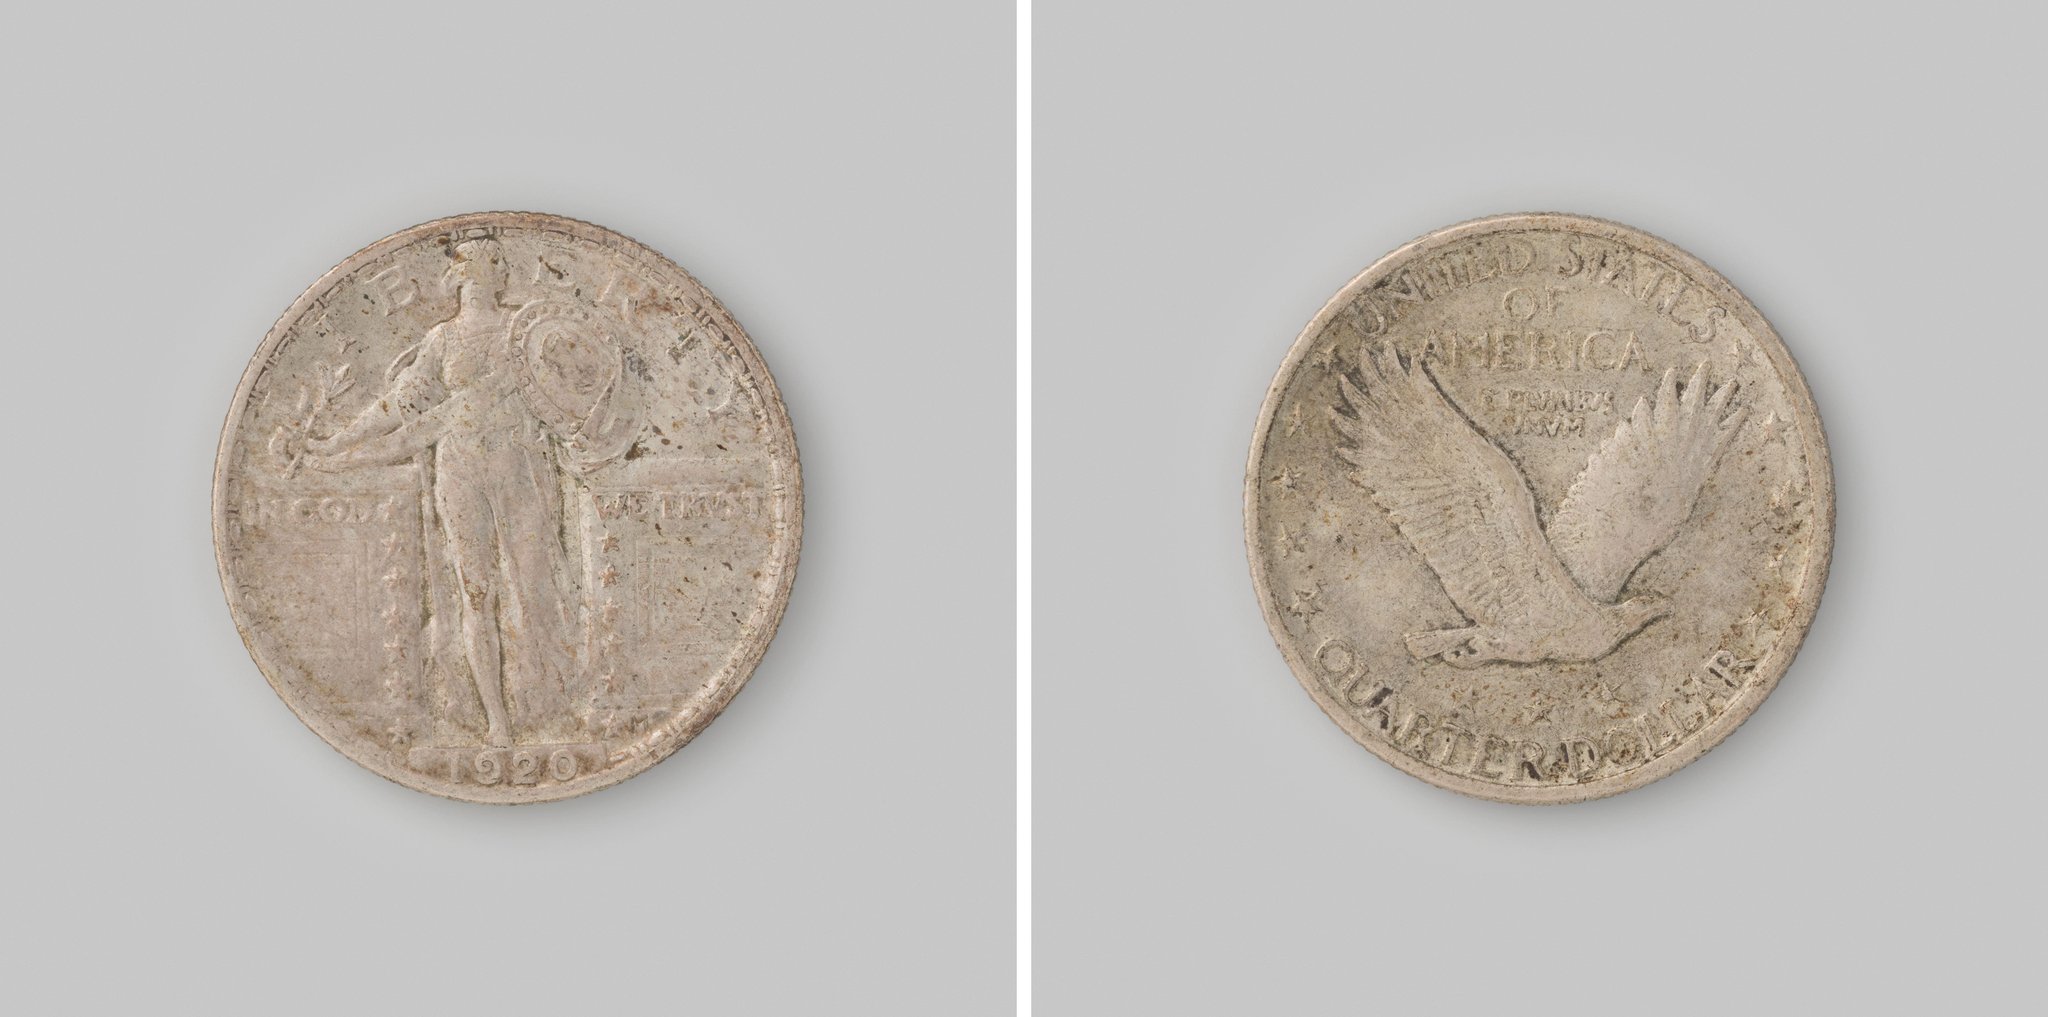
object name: coin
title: 1/4 dollar uit de Verenigde Staten van Amerika, 1920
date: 1920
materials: silver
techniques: striking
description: Zilveren munt. Voorzijde: liberty van voren, staand in omheining, met in de rechterhand tak en in de linker een ovaal schild. Jaartal onderaan. Keerzijde: vliegende duif naar rechts. Daaromheen sterren. Waarde-aanduiding: quarter dollar onderaan. Kartelrand.